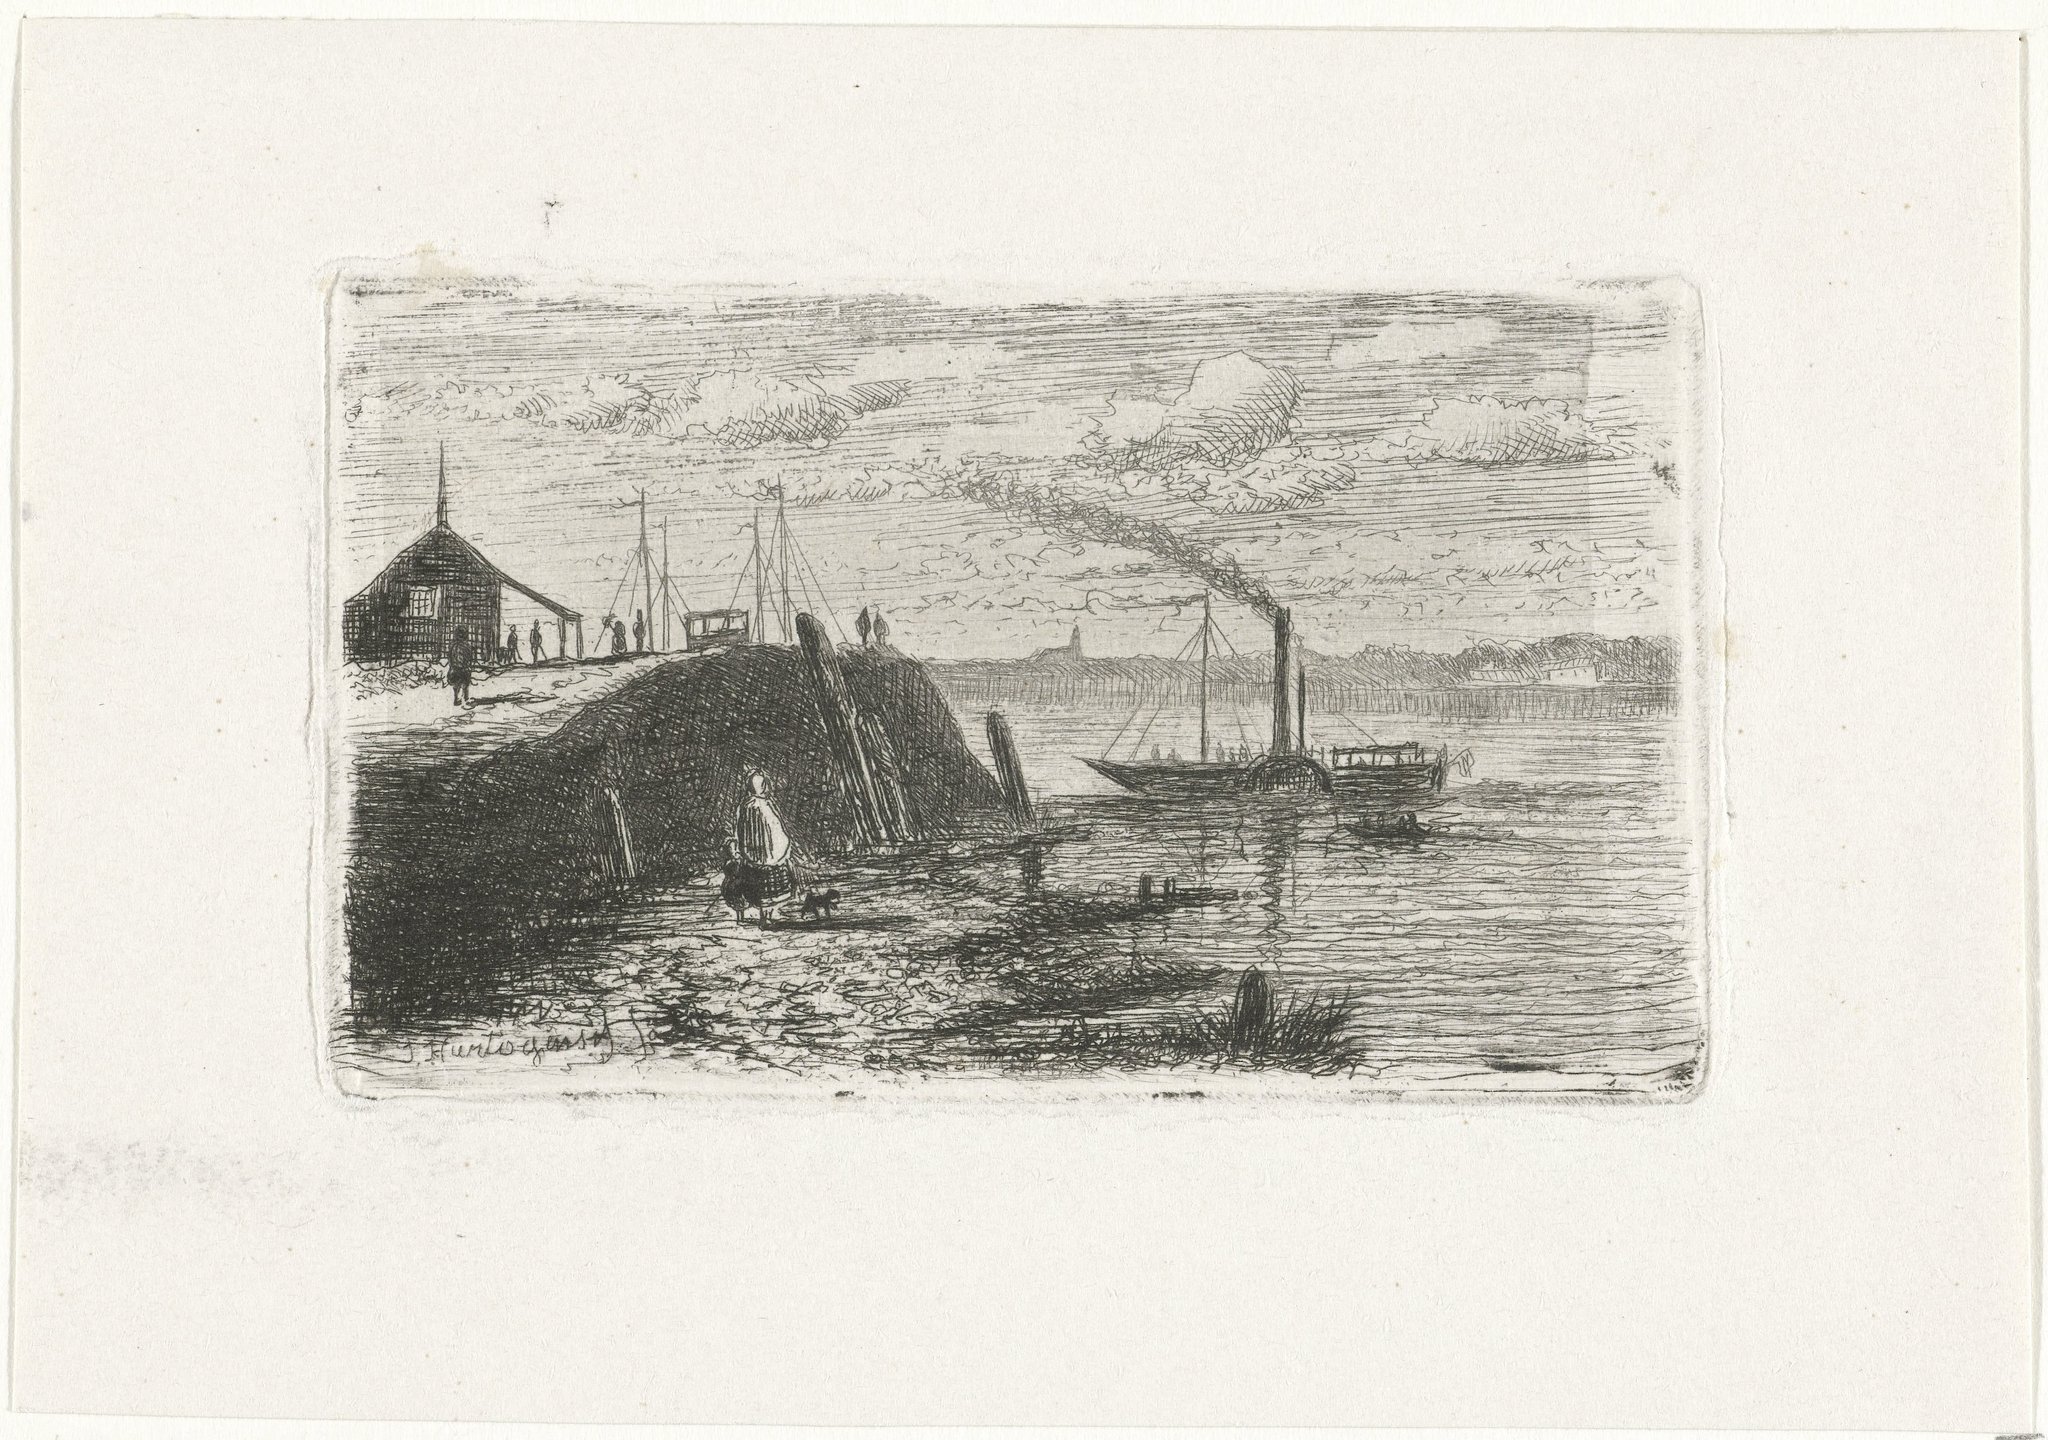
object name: print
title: Omstreek van Zaltbommel, met stoomboot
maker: joseph hartogensis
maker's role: painter, print maker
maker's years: 1822-1865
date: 1854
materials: paper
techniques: etching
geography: the hague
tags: river (+ landscape with figures, staffage), steamship, motorship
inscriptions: collector's mark: Lugt 2228